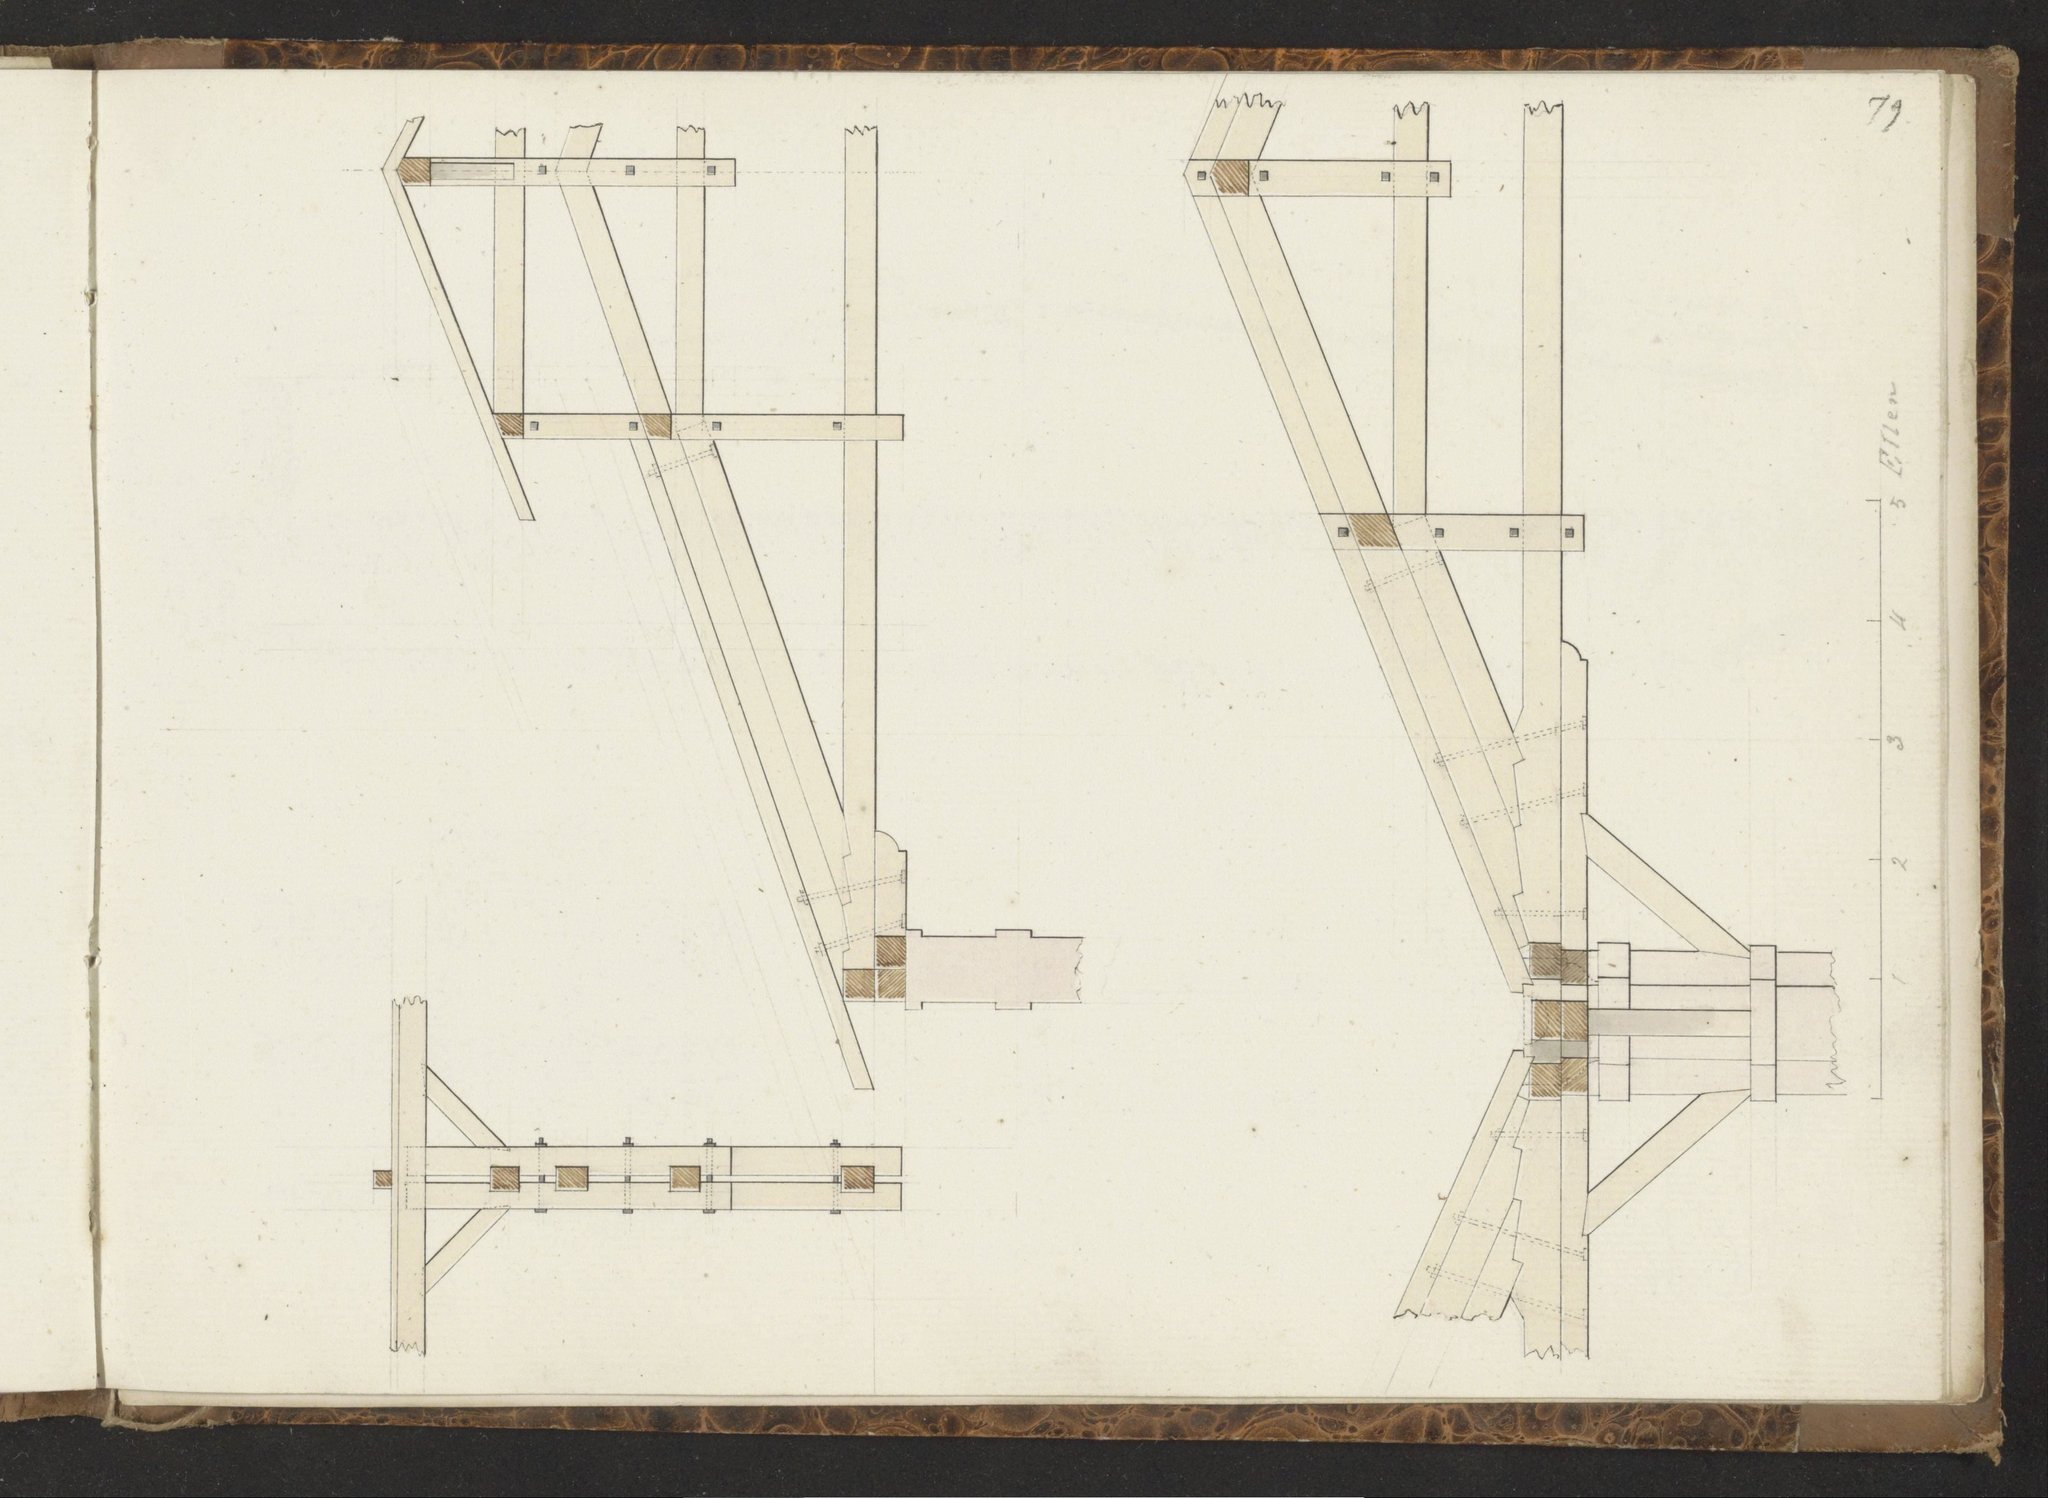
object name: sketchbook leaf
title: Dakconstructie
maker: willem springer jr.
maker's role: draughtsman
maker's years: 1815-1907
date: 1825-1907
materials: ink, paper, pencil, watercolor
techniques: brush, pen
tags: roof (of house or building)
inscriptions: annotation: ‘[...]’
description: Pagina 79 uit een schetsboek met 86 pagina's.